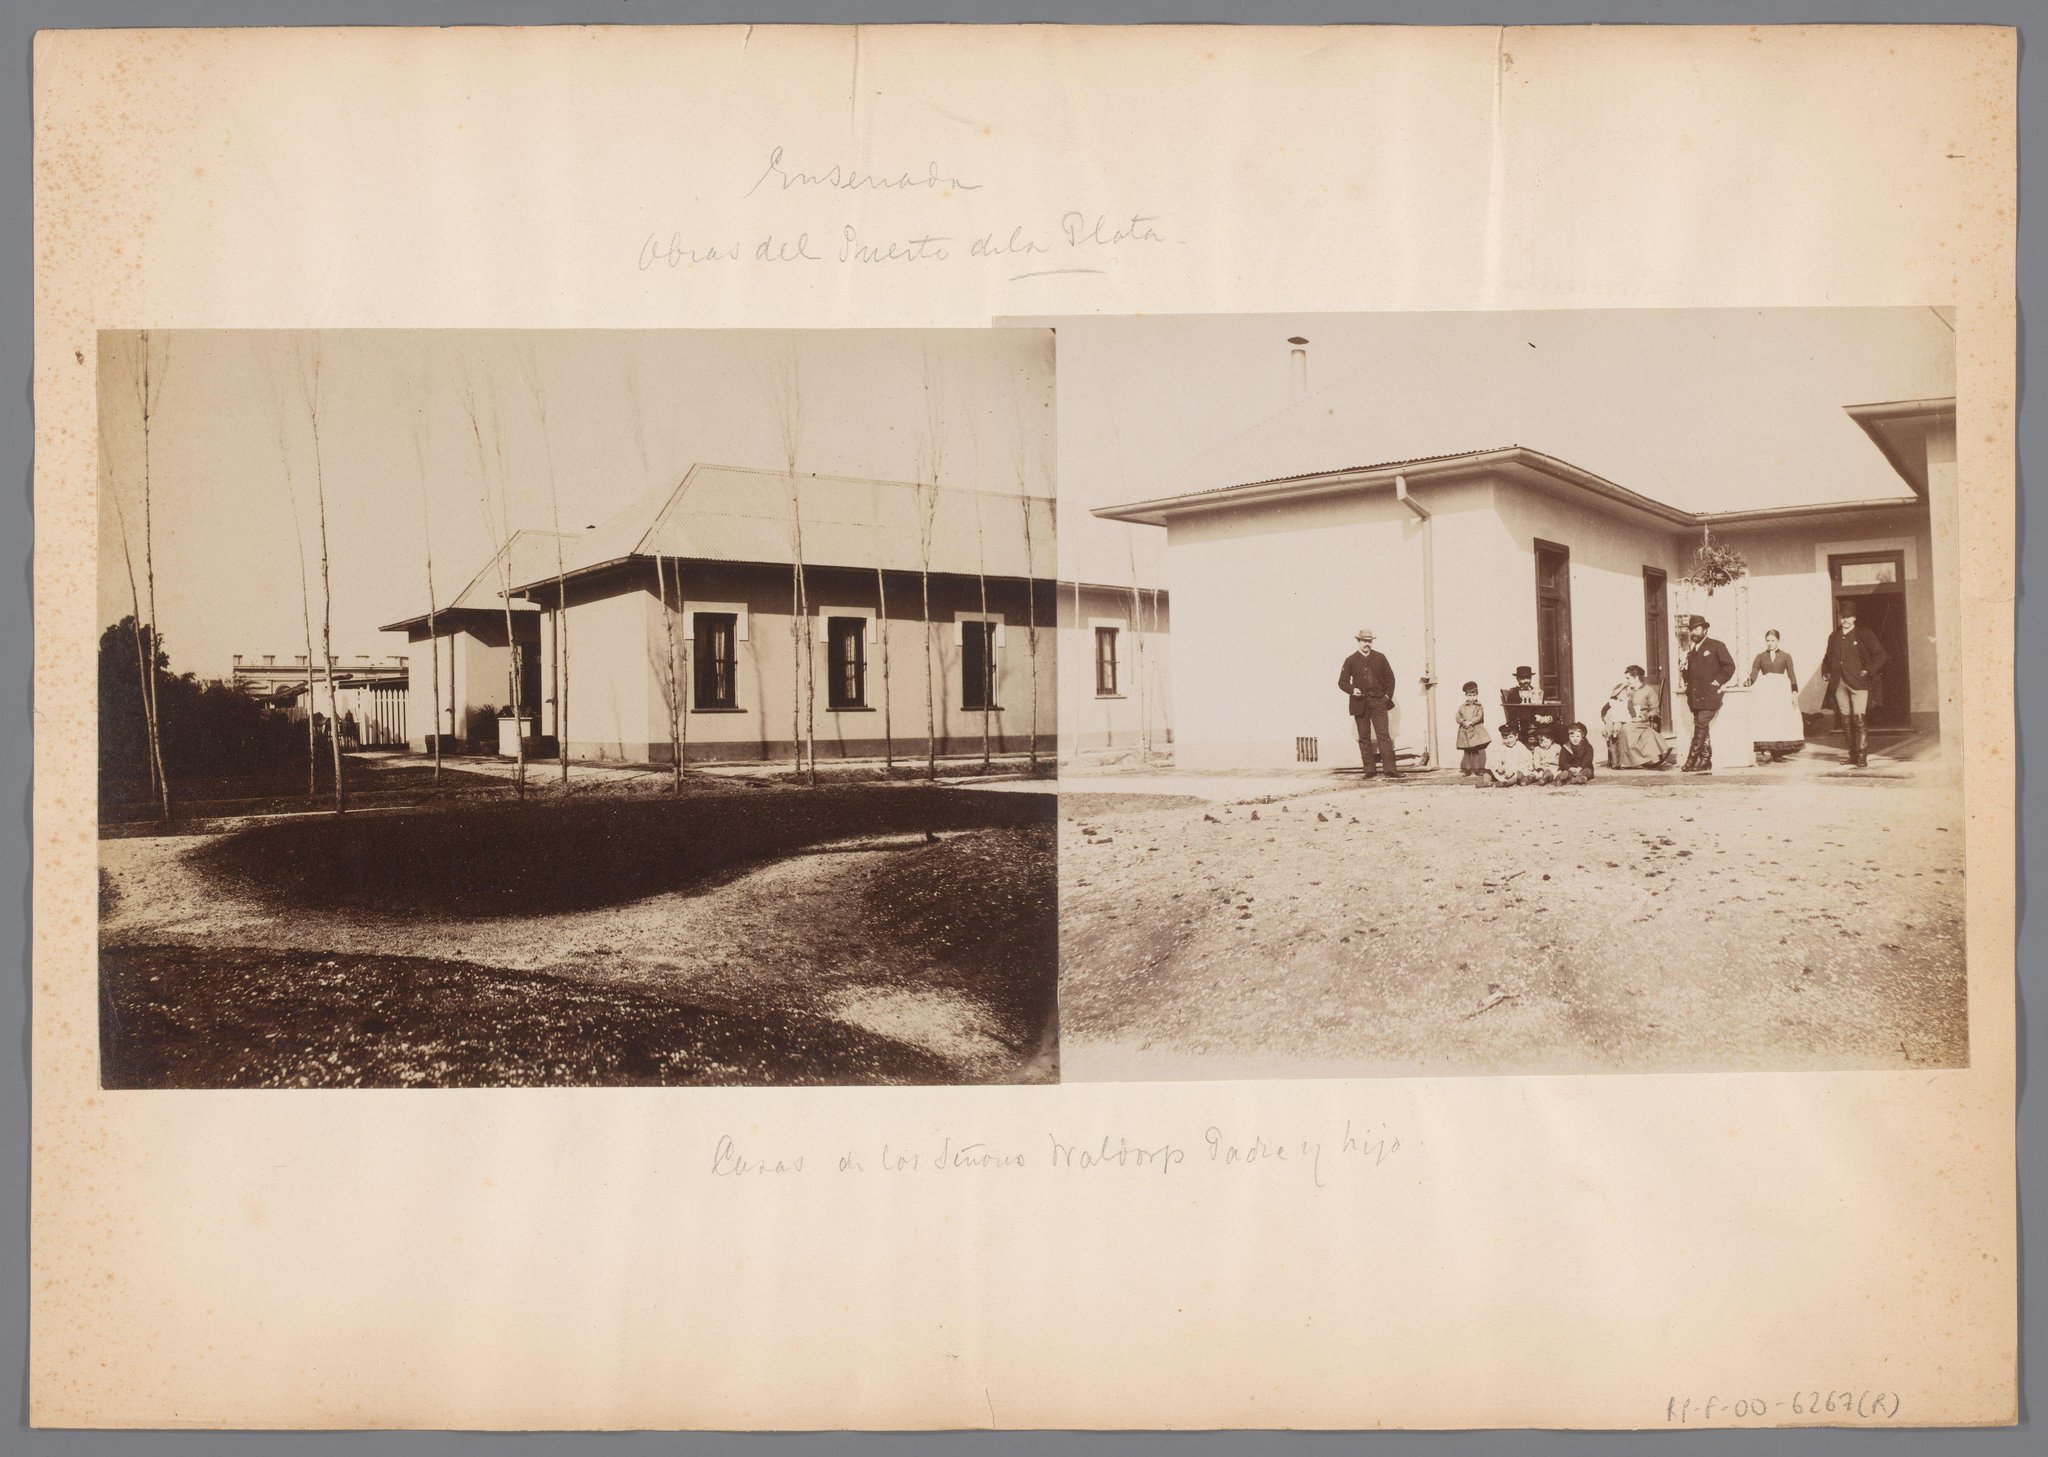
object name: photograph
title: albumblad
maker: Anonymous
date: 1880-1910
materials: cardboard, paper, photographic support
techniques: albumen print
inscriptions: caption: ‘Casas de los signores Waldorp Padre y hijo’, inscription: ‘Ensenada [?]//Abras ddel Puerto dela Plata’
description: Panorama uit twee delen van een huis en rechts een groep mannen, vrouwen en kinderen poserend voor het huis. De linker helft is veel donkerder gebleven, terwijl de rechter helft van deze brede foto is verbleekt. De plaats is niet duidelijk. Zo bestaan er Ensenada's in Chili, Mexico, Argentinië, Peru, de Verenigde Staten en Puerto Rico. Het is waarschijnlijk in Puerto Rico, omdat de Puerto de la Plata een haven is in de Dominicaanse Republiek. Puerto Rico is een met de Verenigde Staten geassocieerde vrijstaat in het oostelijk deel van de Caribische Zee. Het maakt deel uit van de Grote Antillen, en ligt oostelijk van de Dominicaanse Republiek. Twee foto's van elk 21 cm breed, deels over elkaar heen geplakt.